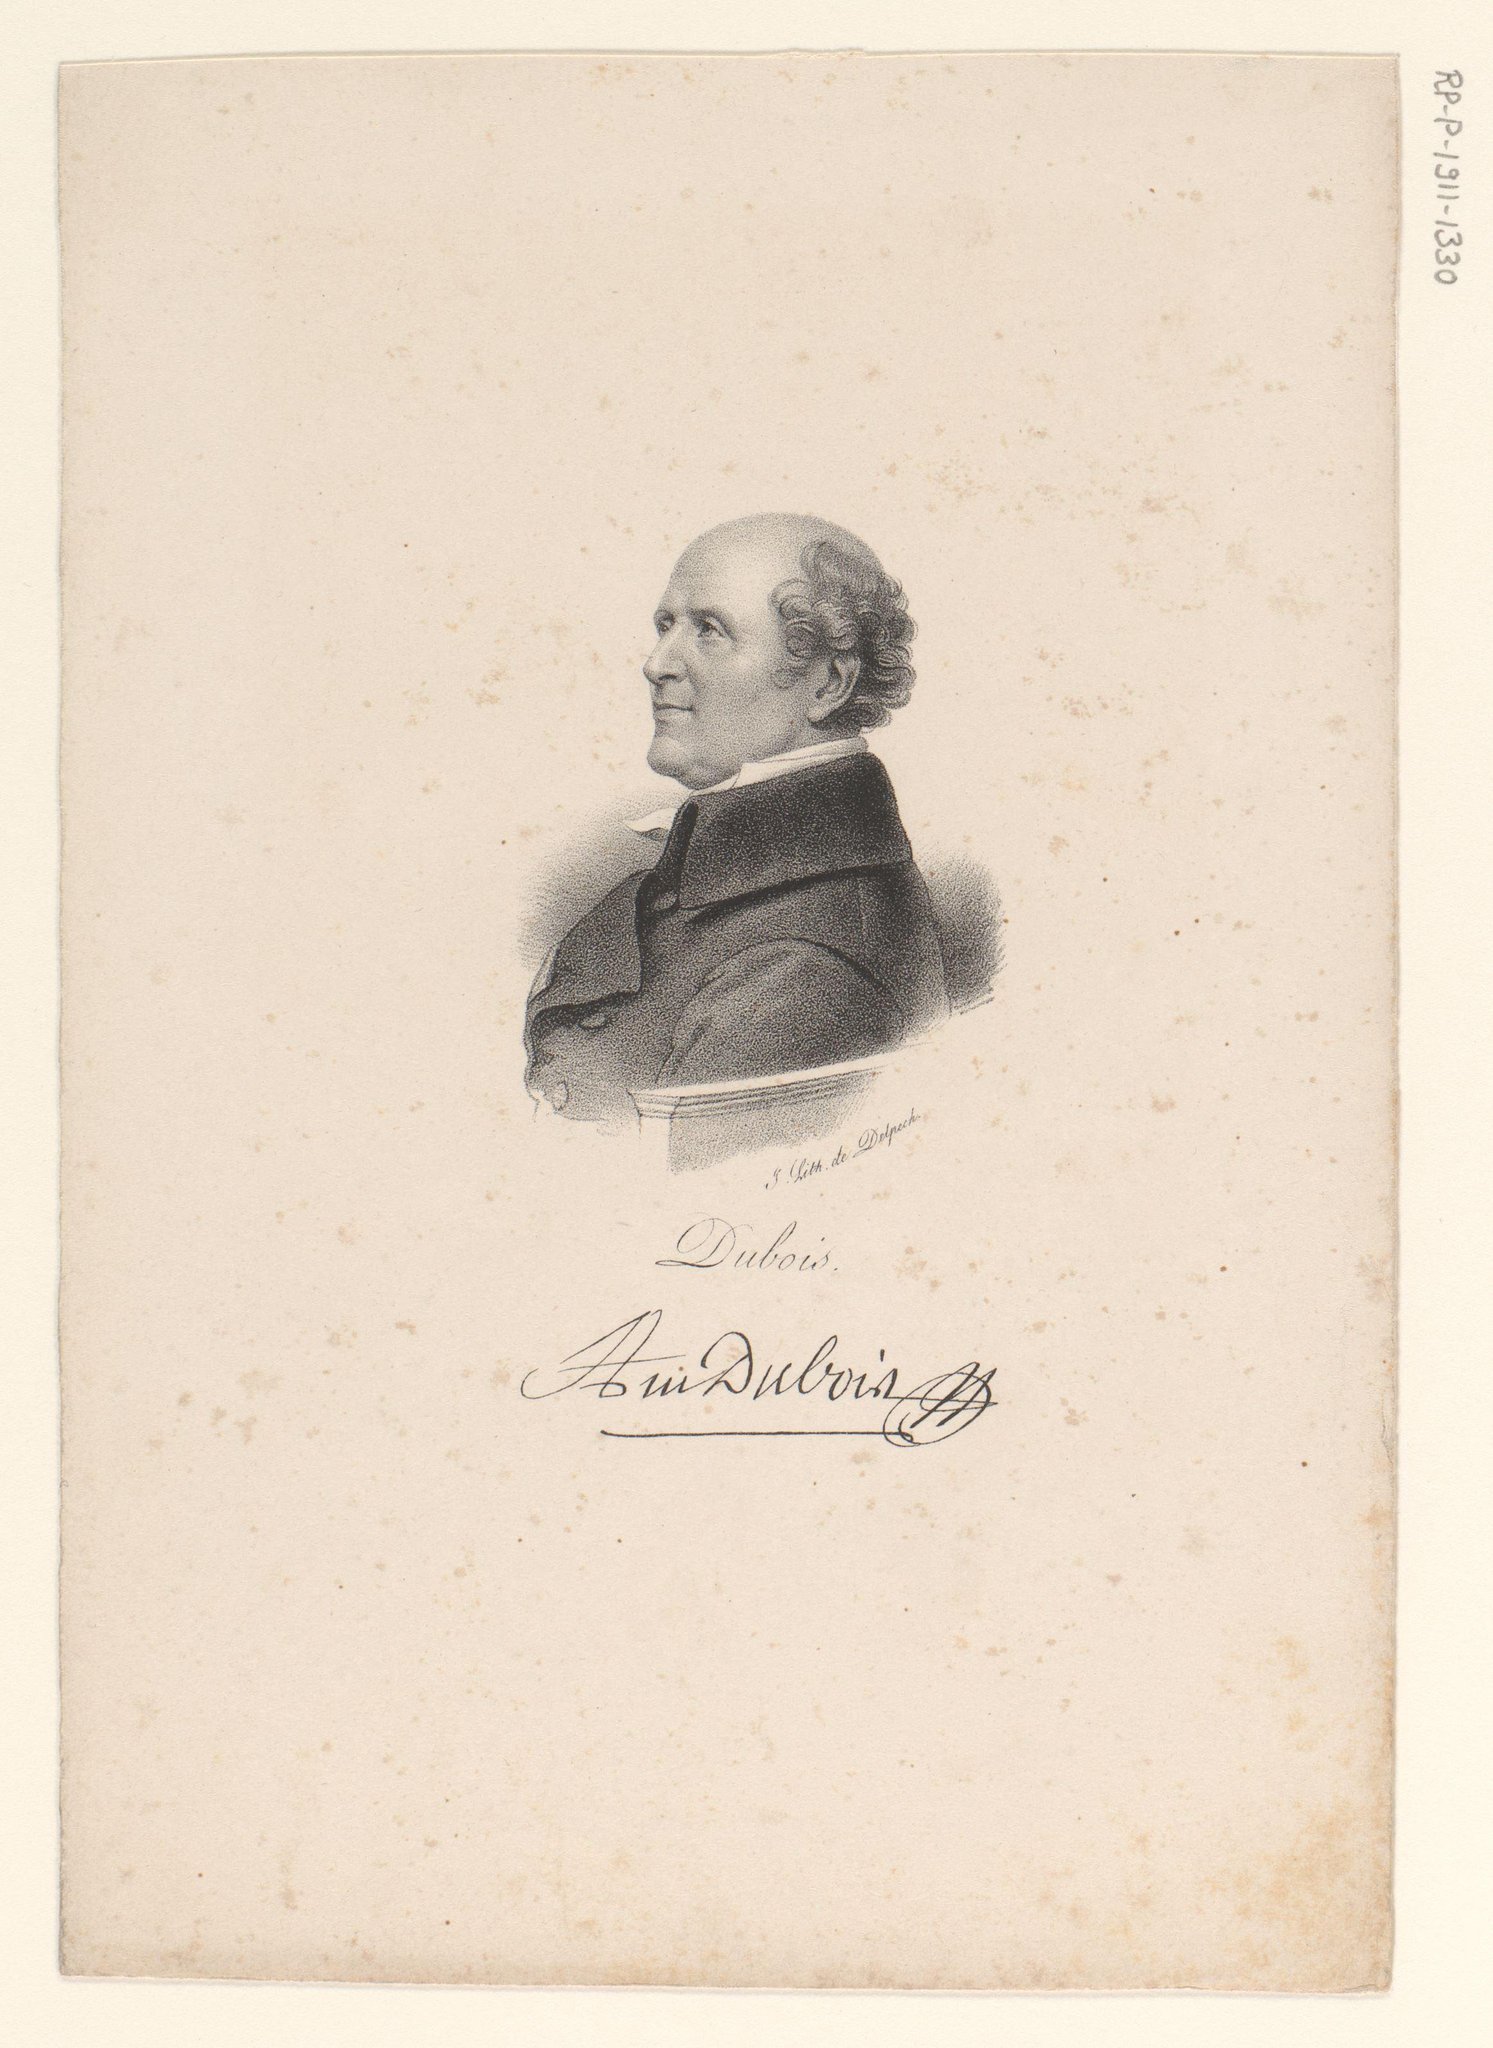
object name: print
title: Dubois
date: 1818-1842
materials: paper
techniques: lithograph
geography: paris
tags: paris, historical persons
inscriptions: collector's mark: Lugt 2228a